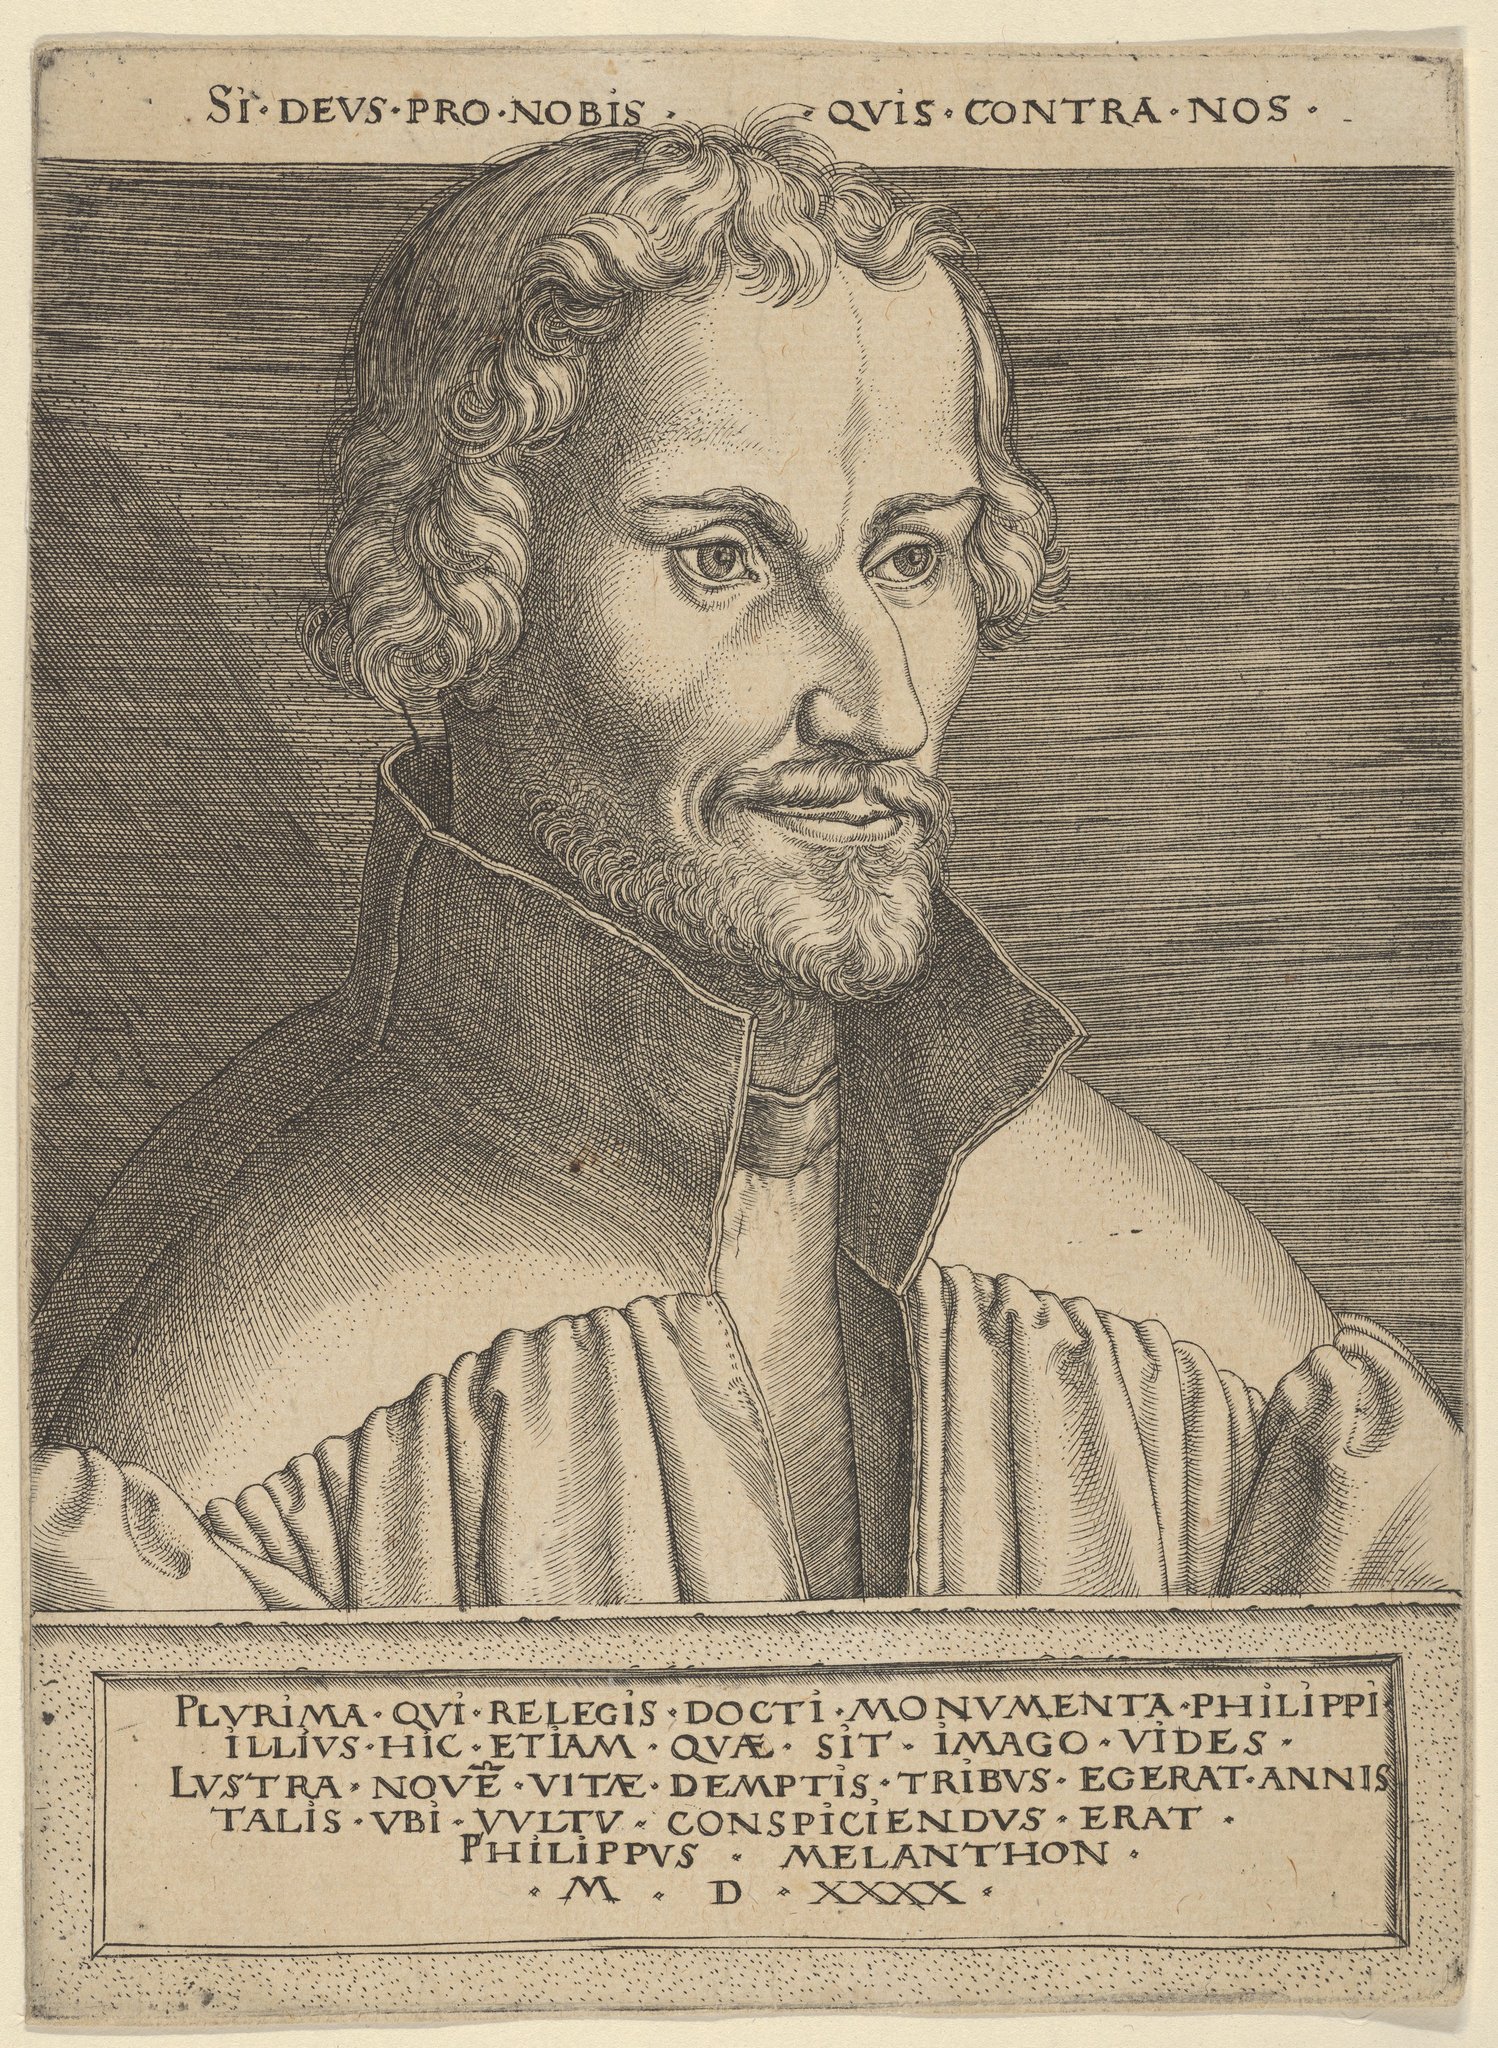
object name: print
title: Philip Melanchthon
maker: heinrich aldegrever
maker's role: artist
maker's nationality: german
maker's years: 1502-1561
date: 1540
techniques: engraving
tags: men,portraits